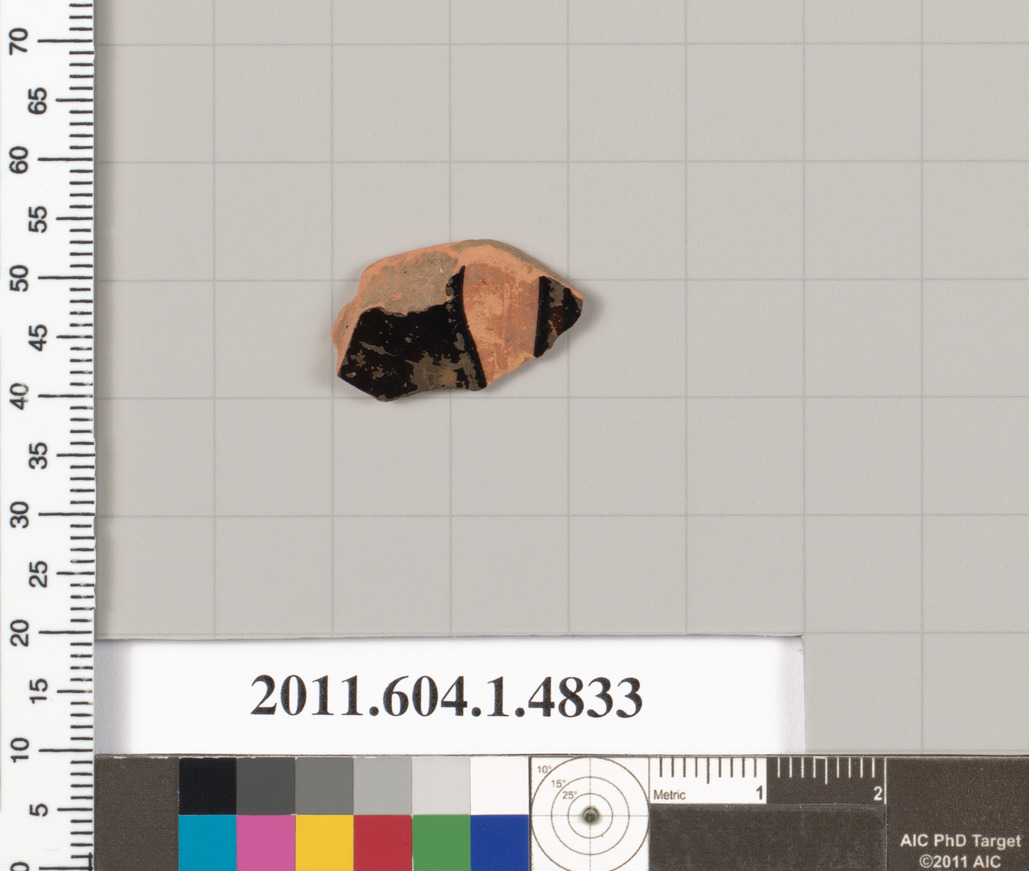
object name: kylix fragment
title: Terracotta fragment of a kylix (drinking cup)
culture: greek, attic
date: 500-480 BCE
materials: terracotta